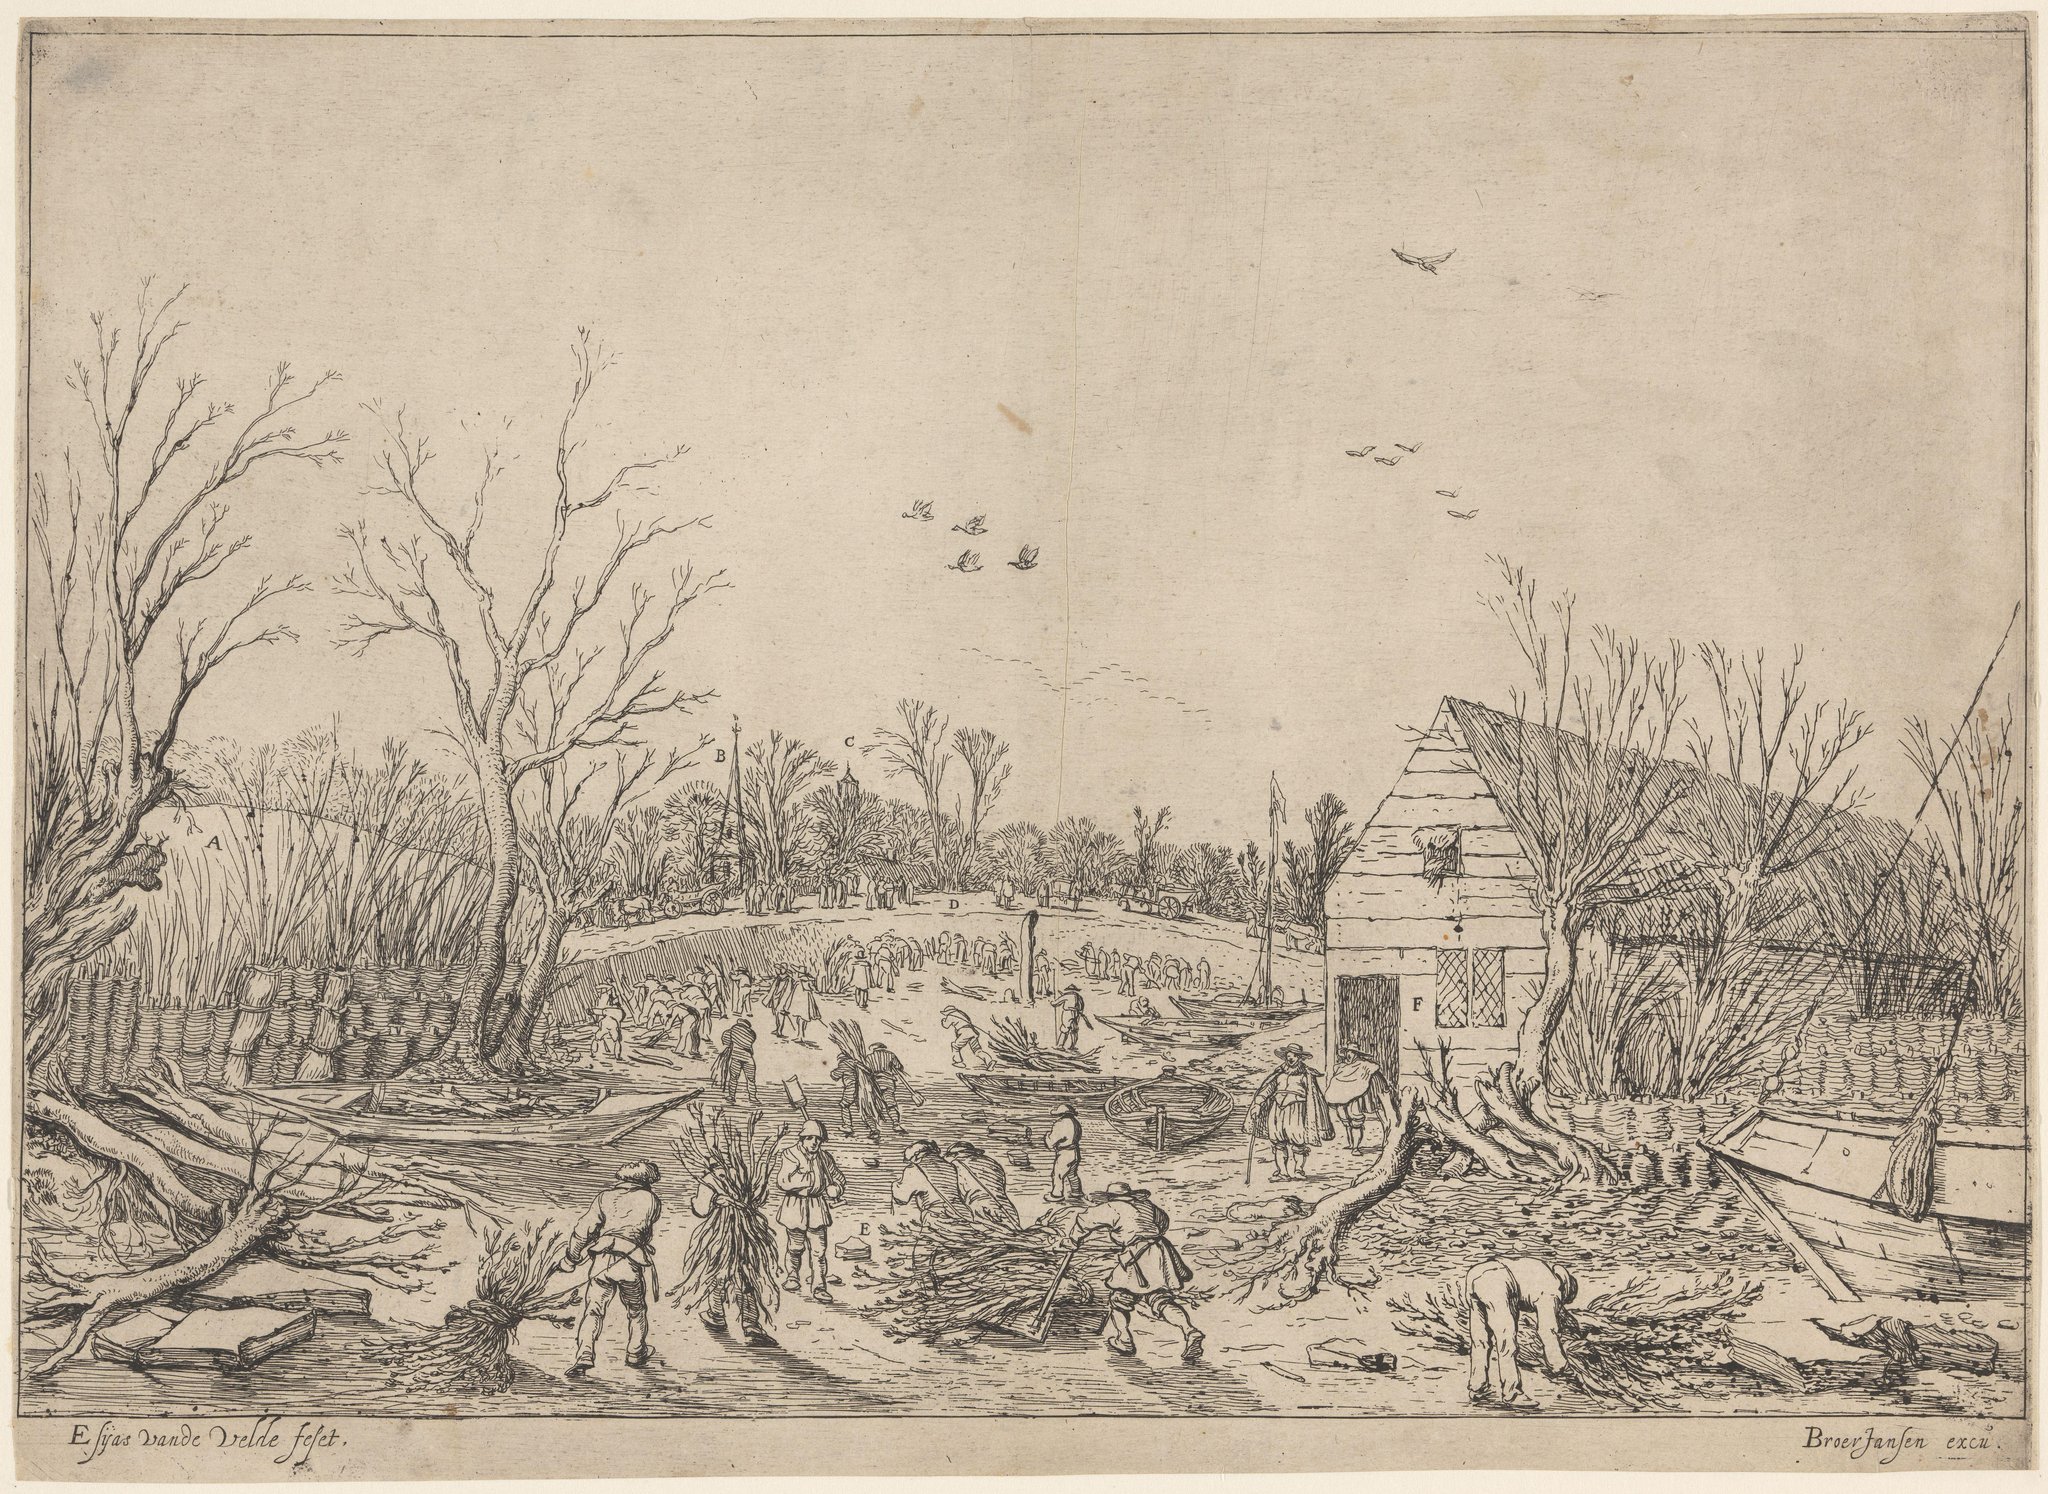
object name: print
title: Herstellen van de doorgebroken dijk bij Vianen, 1624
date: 1624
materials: paper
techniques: etching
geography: amsterdam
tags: dike-break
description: Het herstellen van de doorgebroken dijk langs de Lek bij Vianen, na de dijkdoorbraak en overstroming op 10 januari 1624. In de verte de Dom van Utrecht. Bij de prent behoort een tekstblad met uitleg en legenda.